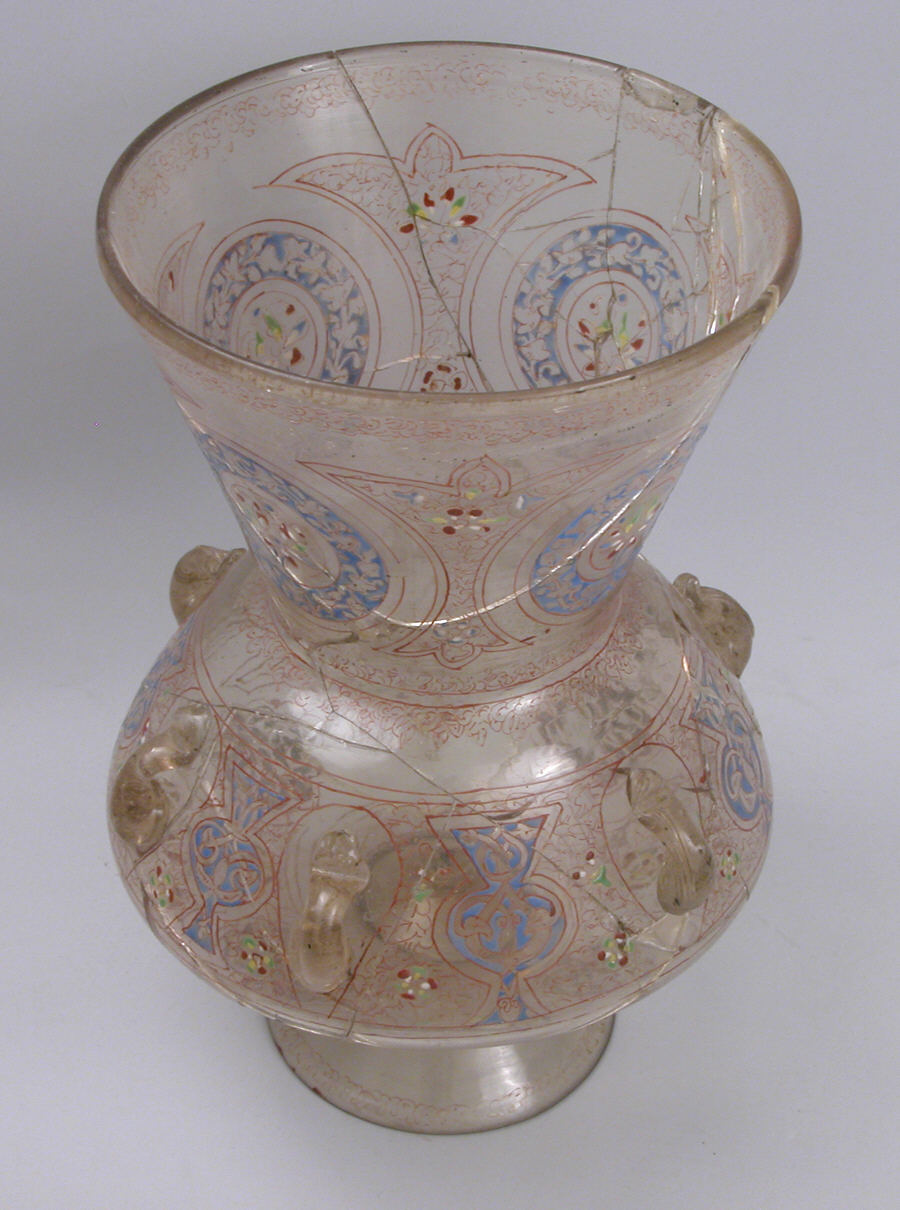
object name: mosque lamp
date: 1301-1350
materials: glass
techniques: enamel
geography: egypt or syria